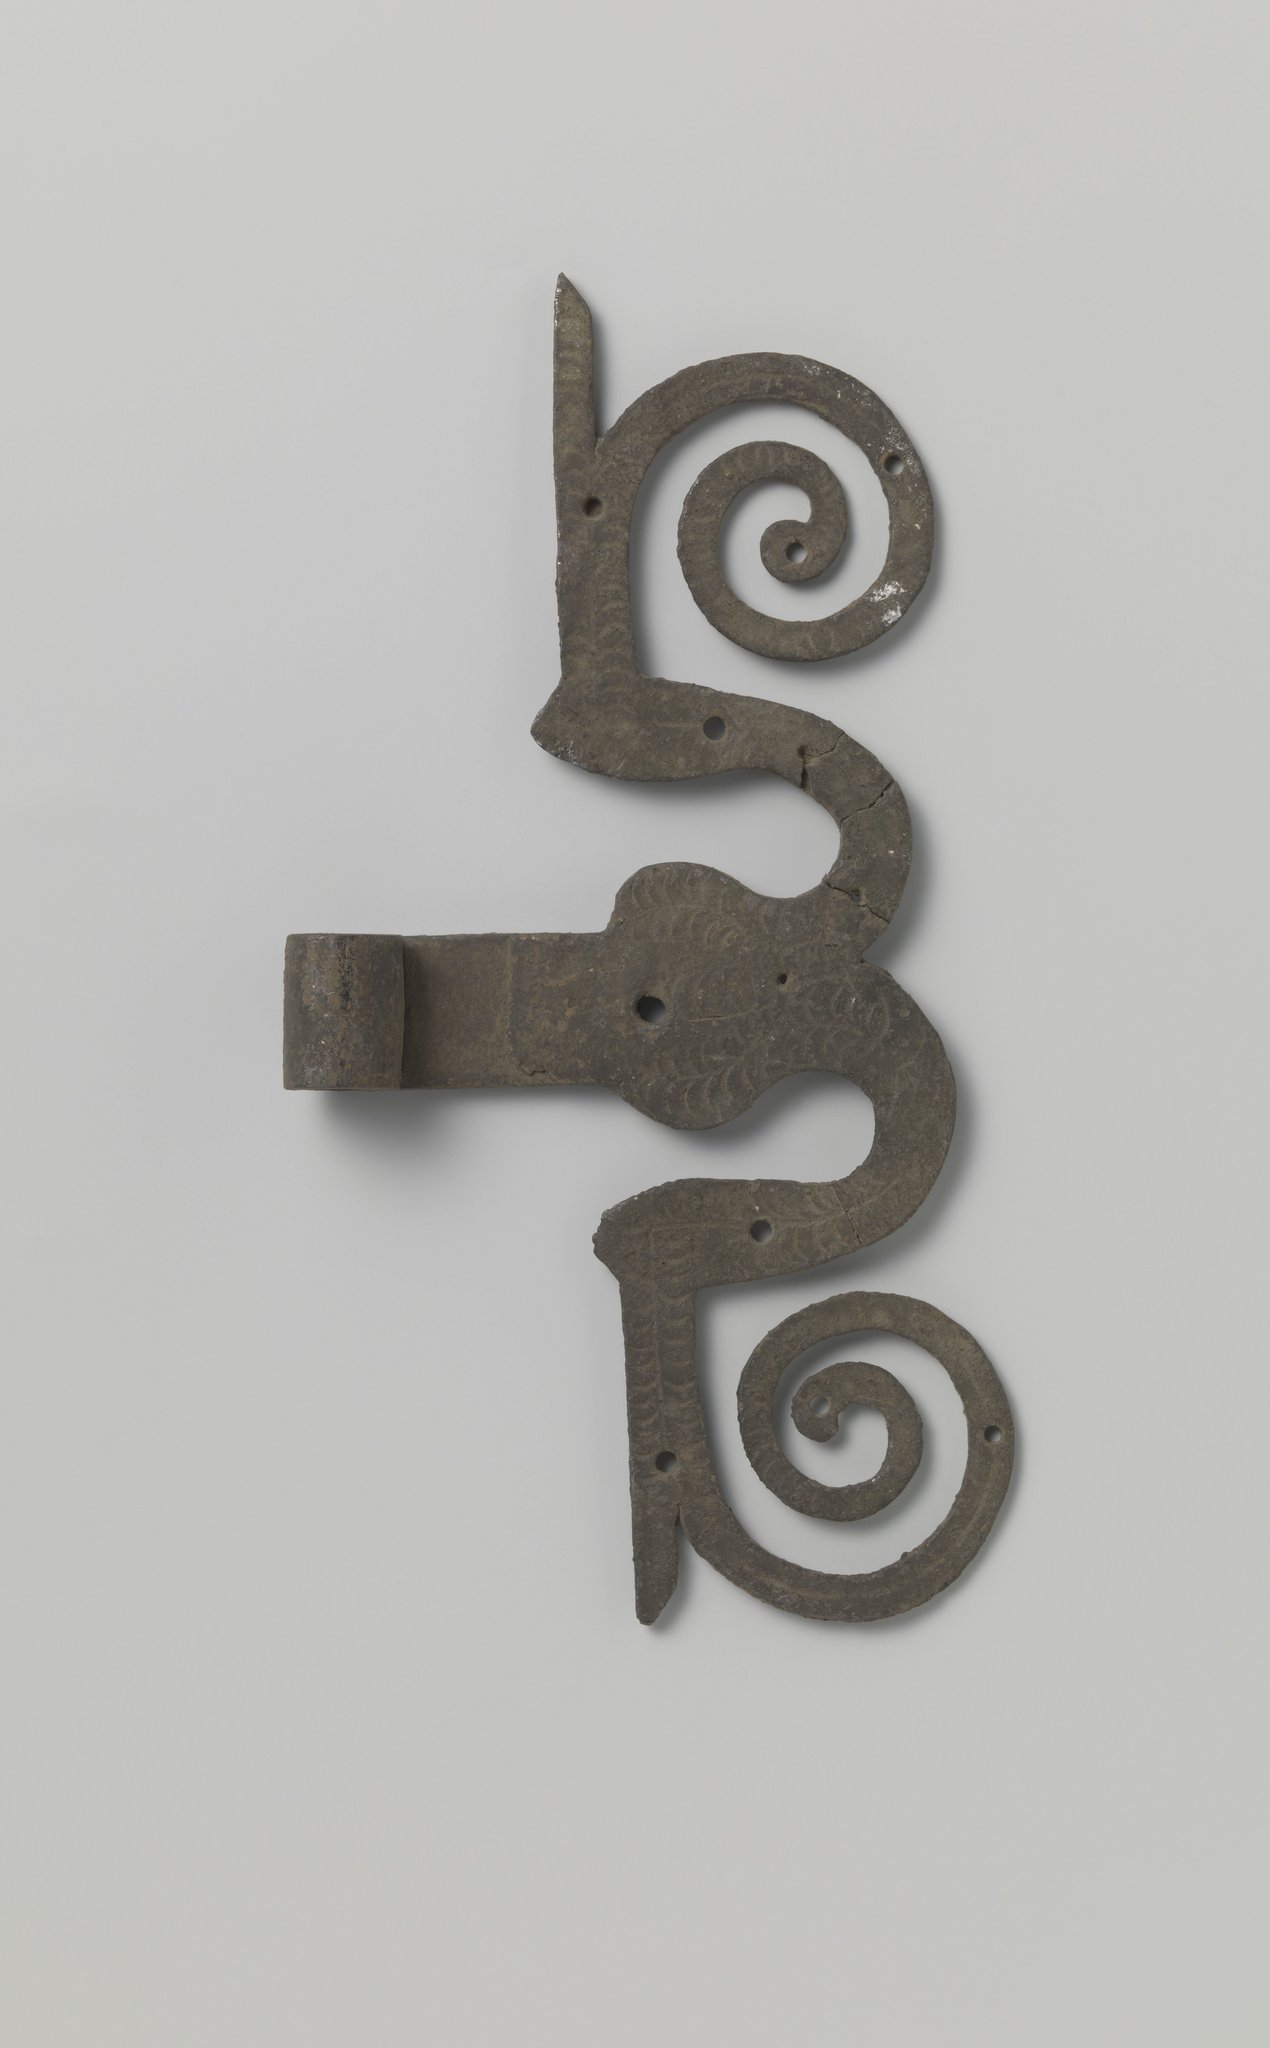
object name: deurhengsel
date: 1400-1950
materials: iron